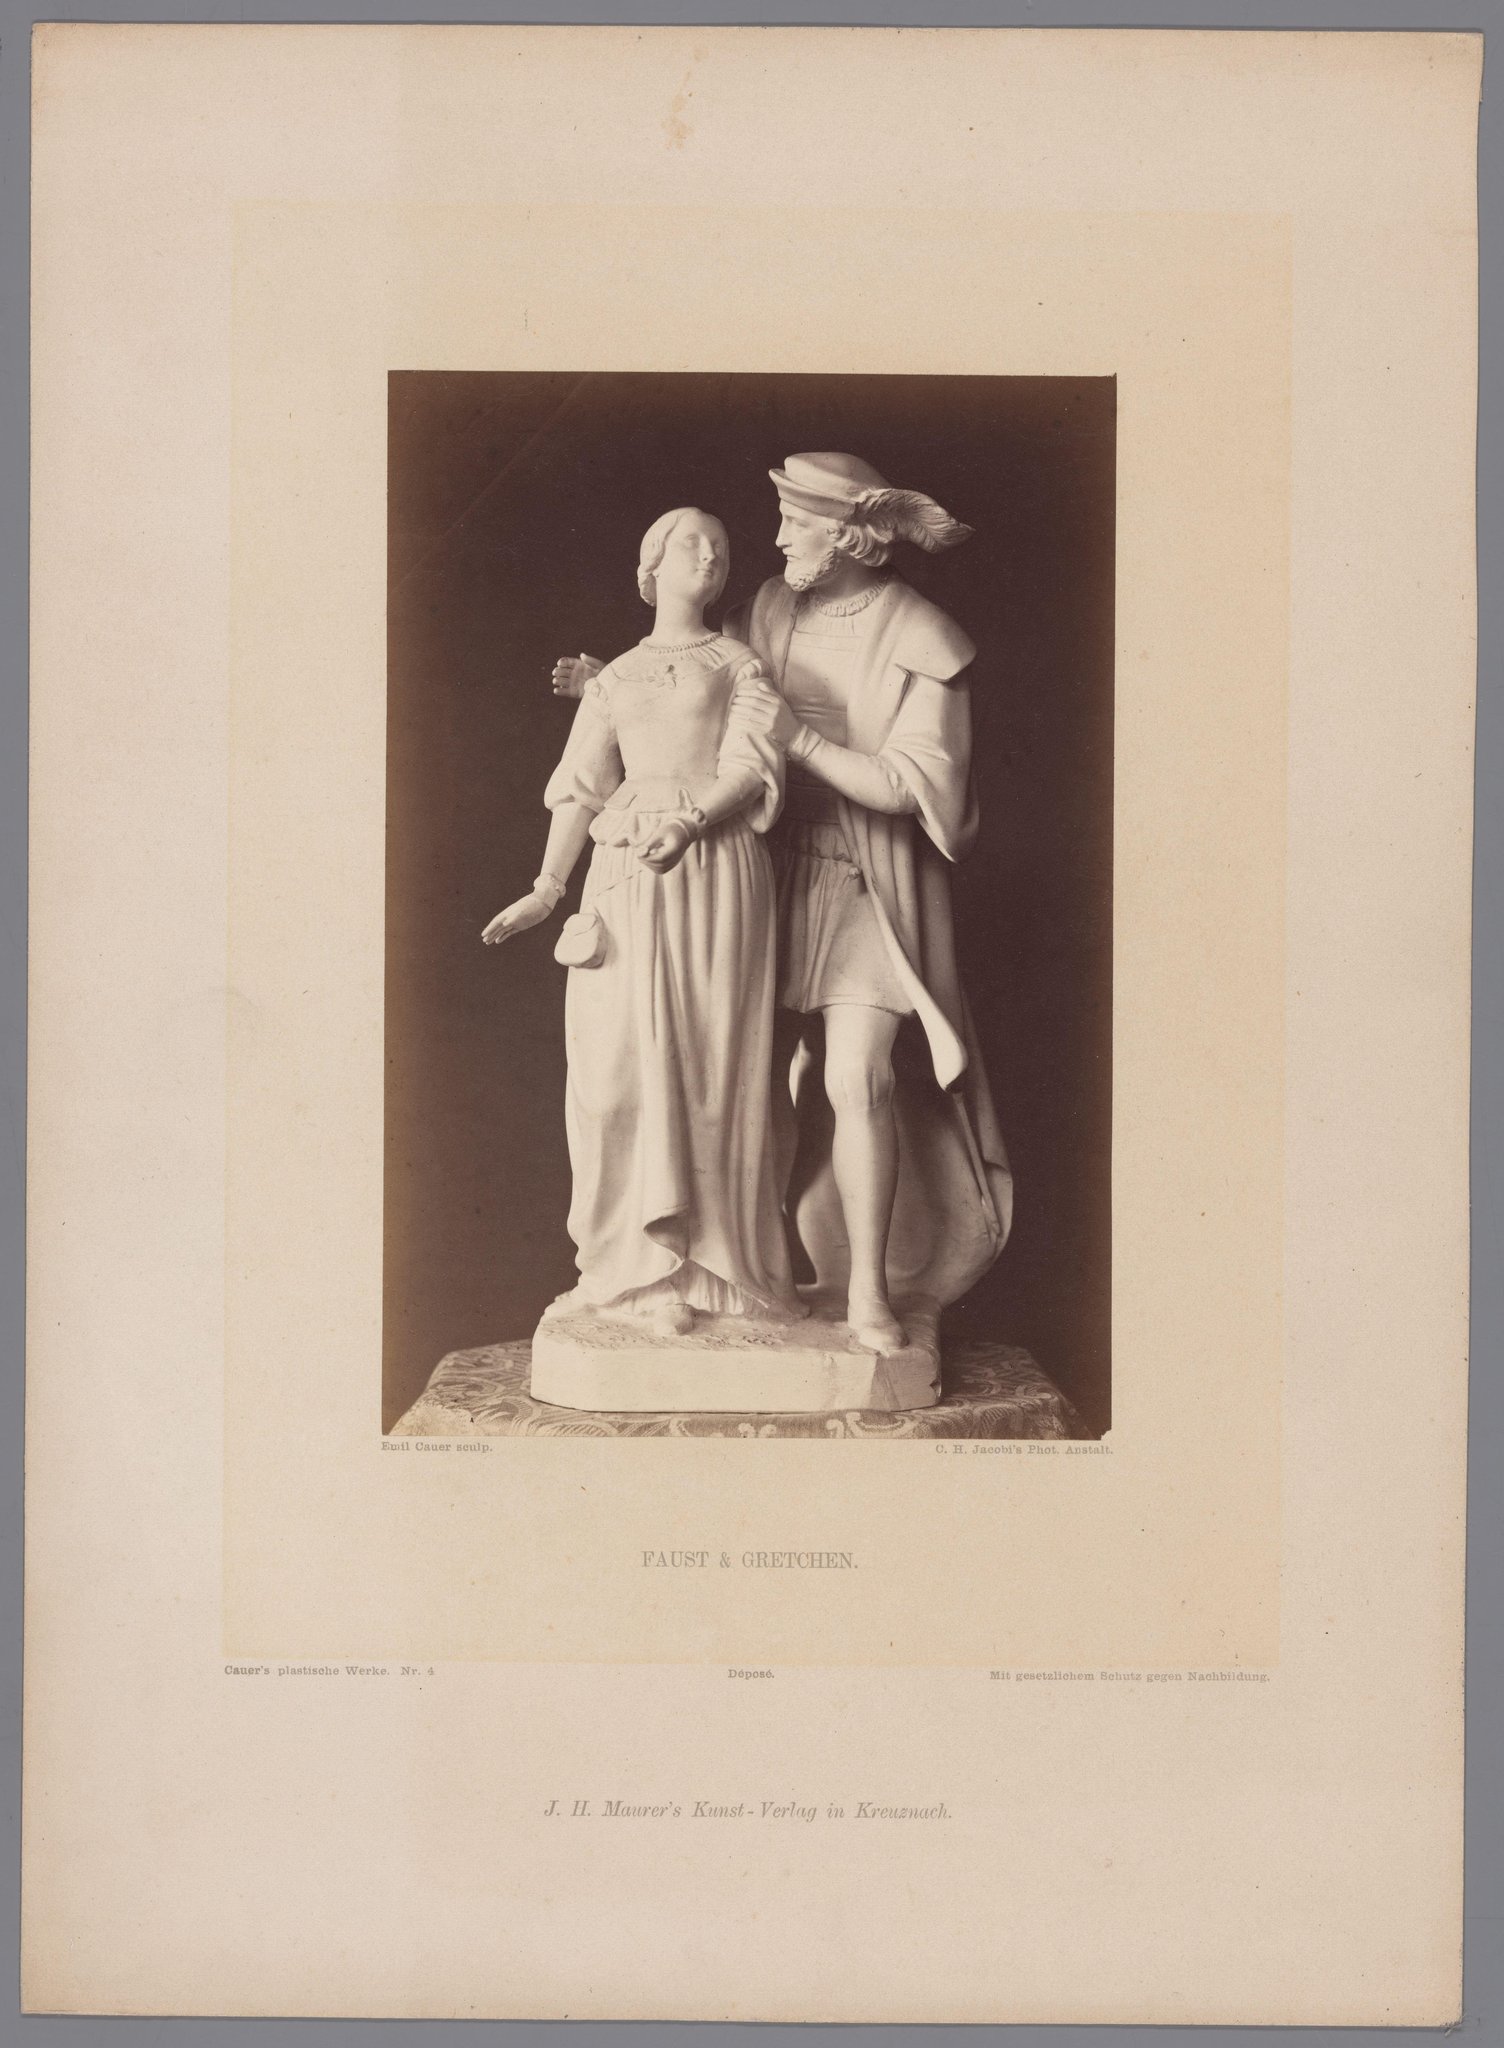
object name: photograph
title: Faust & Gretchen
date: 1850-1900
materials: cardboard, photographic support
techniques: albumen print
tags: gretchen, faust, sculpture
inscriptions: inscription: ‘Robert Cauer sculp./Cauer's plastische Werke. Nr. 4 Déposé. Mit gesetzlichem Schutz gegen Nachbildung’